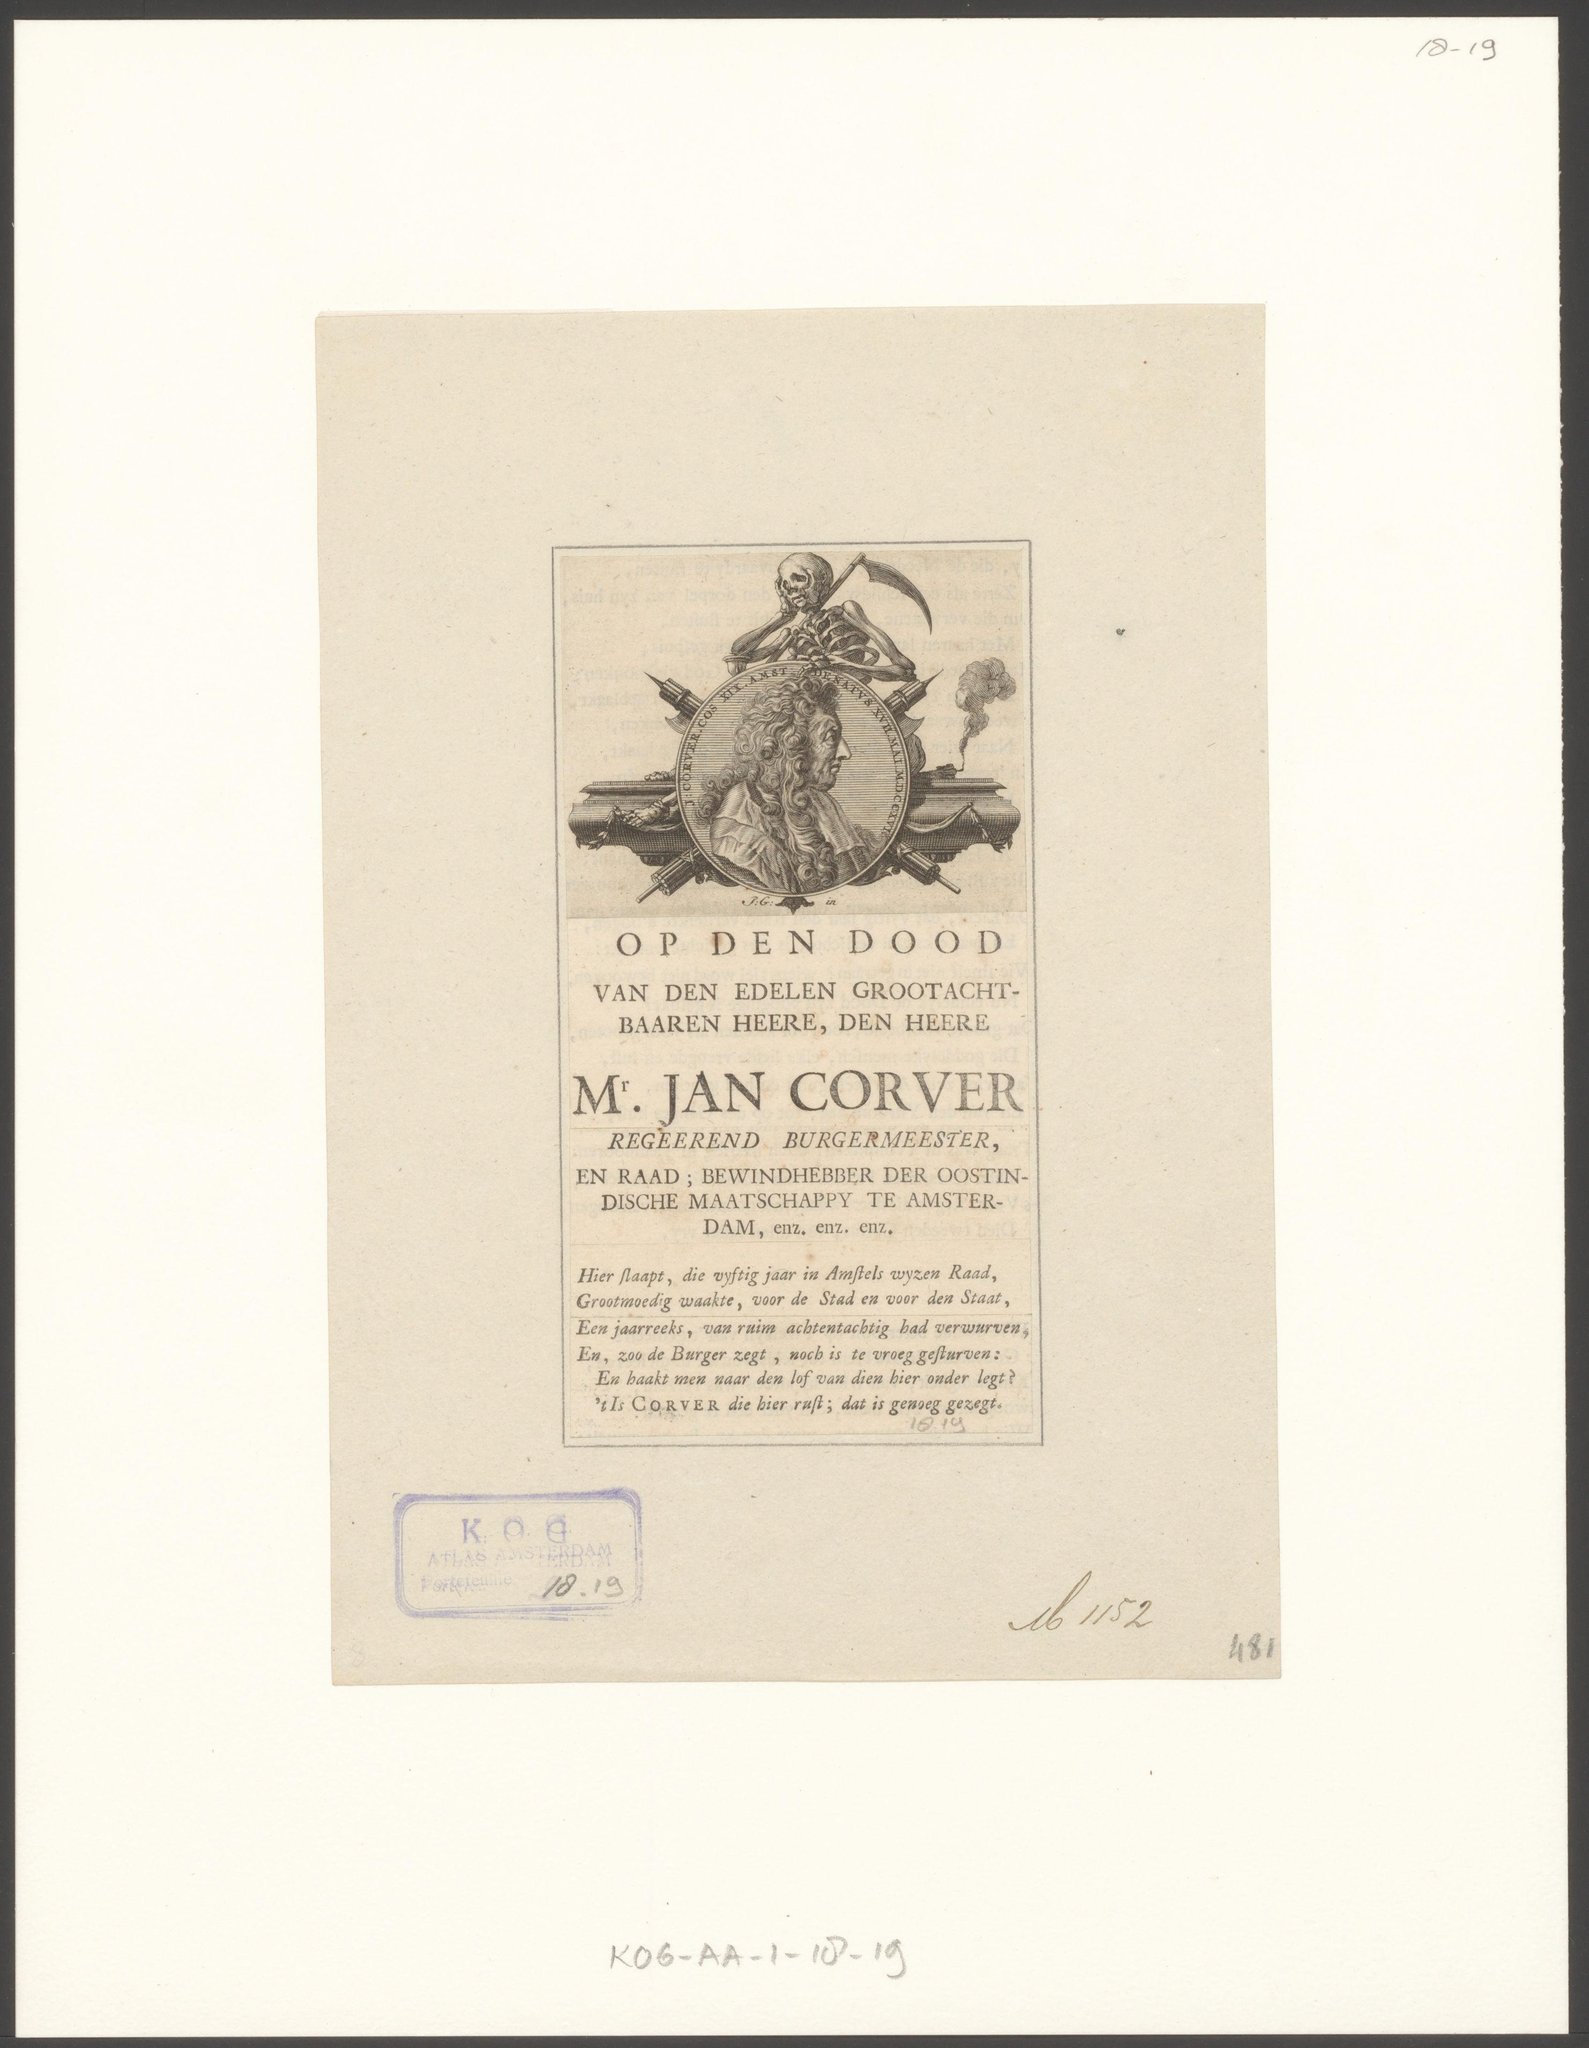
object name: print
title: Medaille met het portret van Joan Corver met tekst ter nagedachtenis aan zijn overlijden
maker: jan goeree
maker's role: draughtsman, print maker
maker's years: 1670-1731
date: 1716-1731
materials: paper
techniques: engraving, etching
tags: amsterdam, mayor, mayor, burgomaster, death as skeleton, historical persons, agricultural implements: sickle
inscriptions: collector's mark: ‘18.19’ Lugt 1641b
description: Onderwerpsrubriek binnen de Atlas Amsterdam: Herinneringen aan regeringsleden en hunne huisgezinnen [voor 1800].